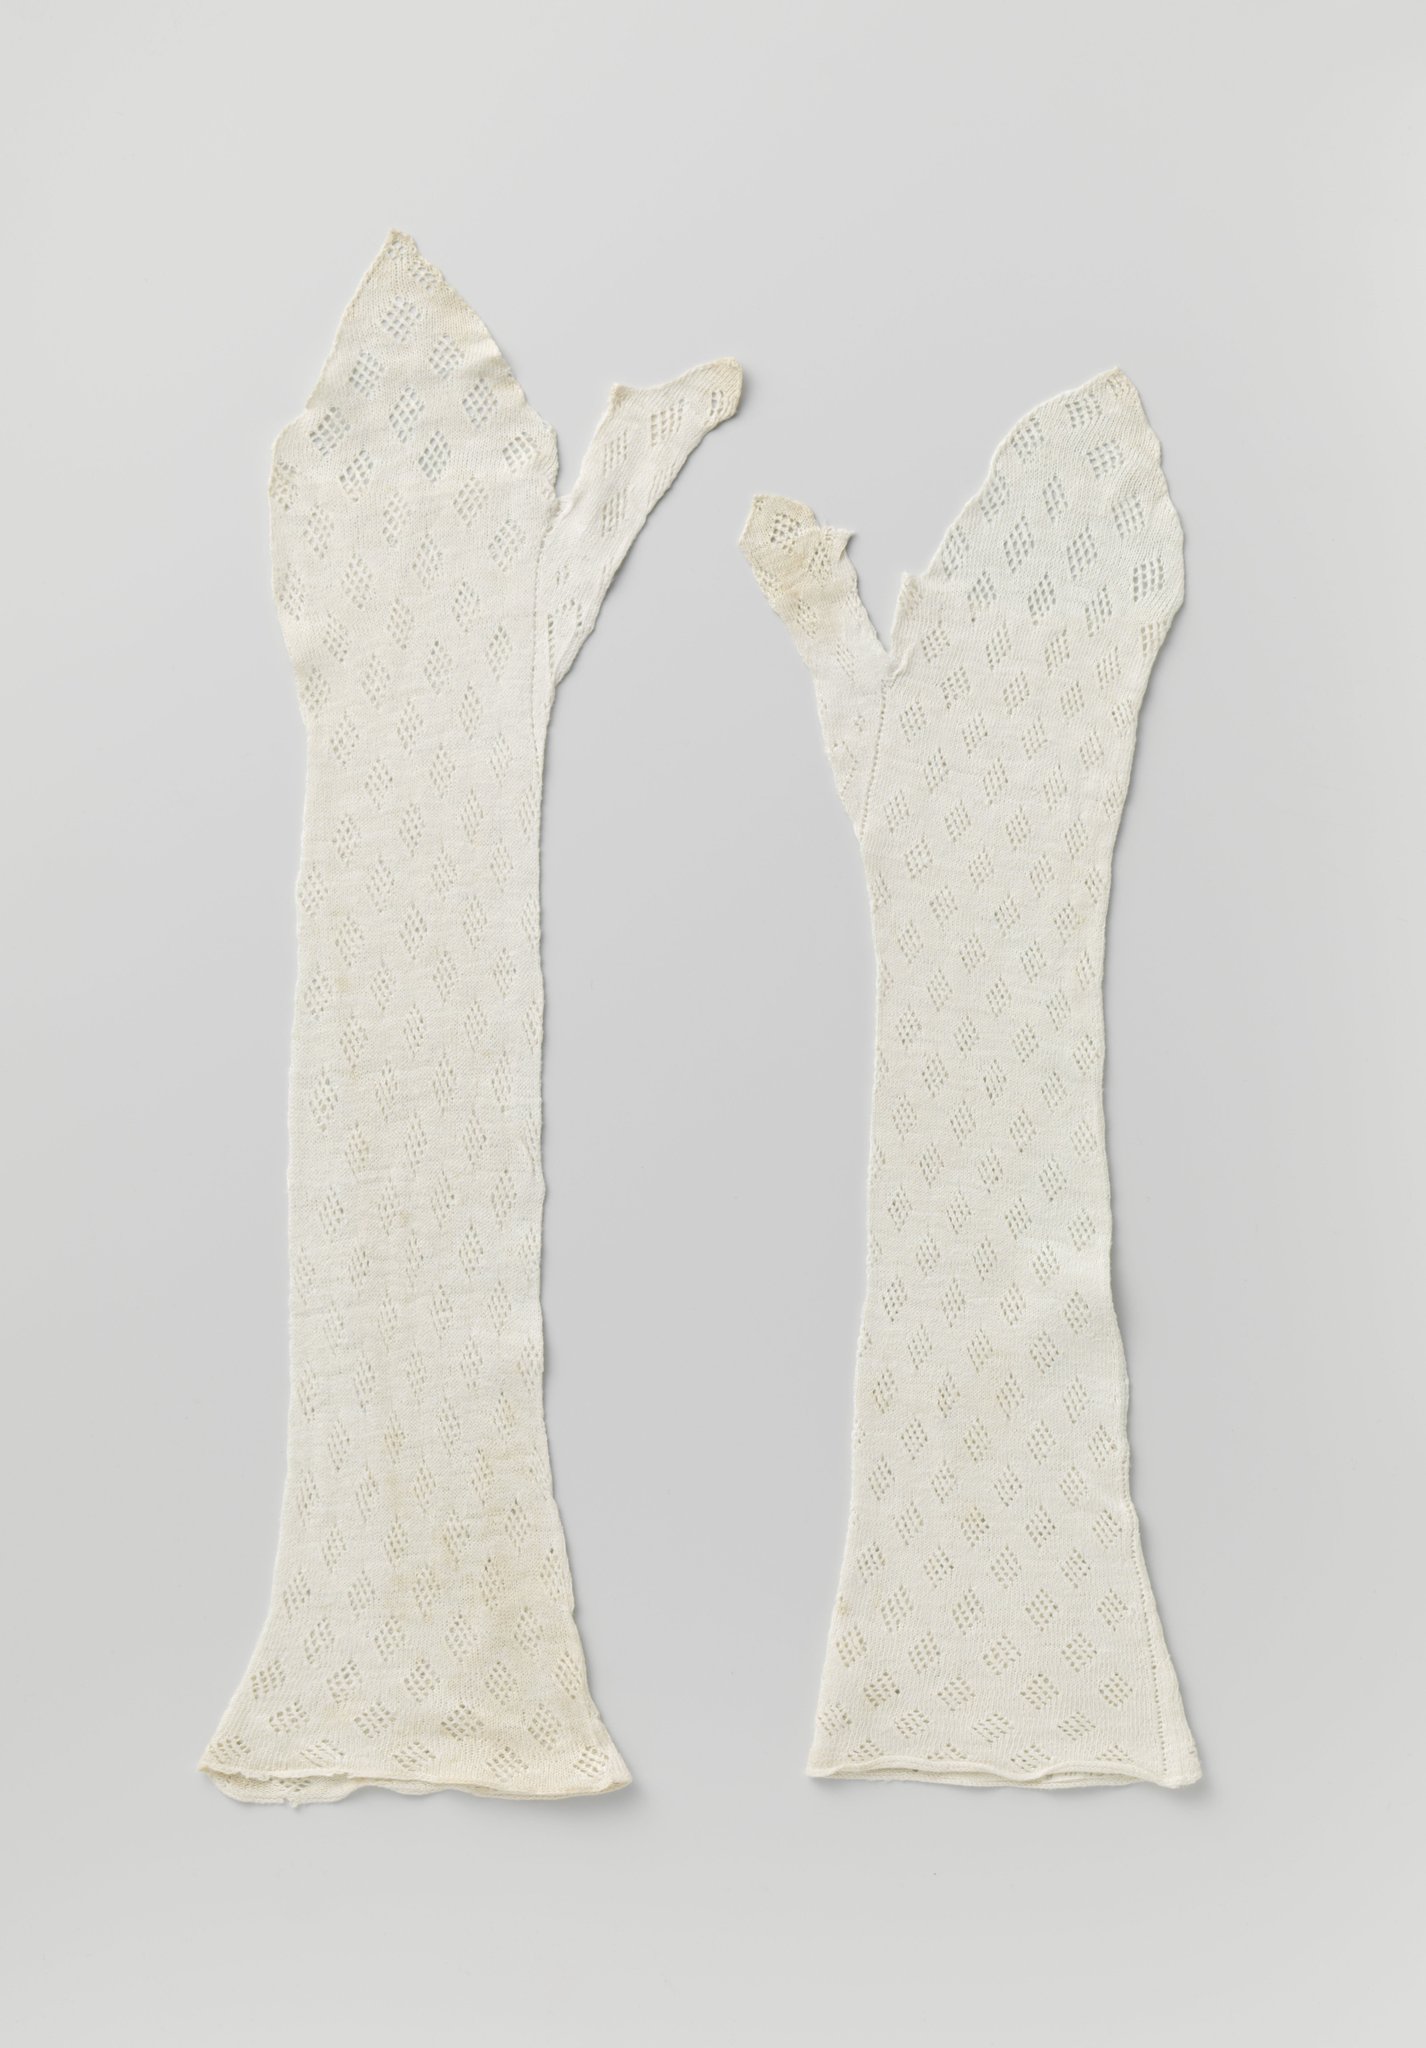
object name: clothing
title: Mitaine van witte gebreide katoen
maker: Anonymous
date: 1800-1820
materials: cotton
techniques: knitting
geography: western europe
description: Linker mitaine van witte gebreide katoen met een open duim, versierd met een patroon van ajour ruitjes.